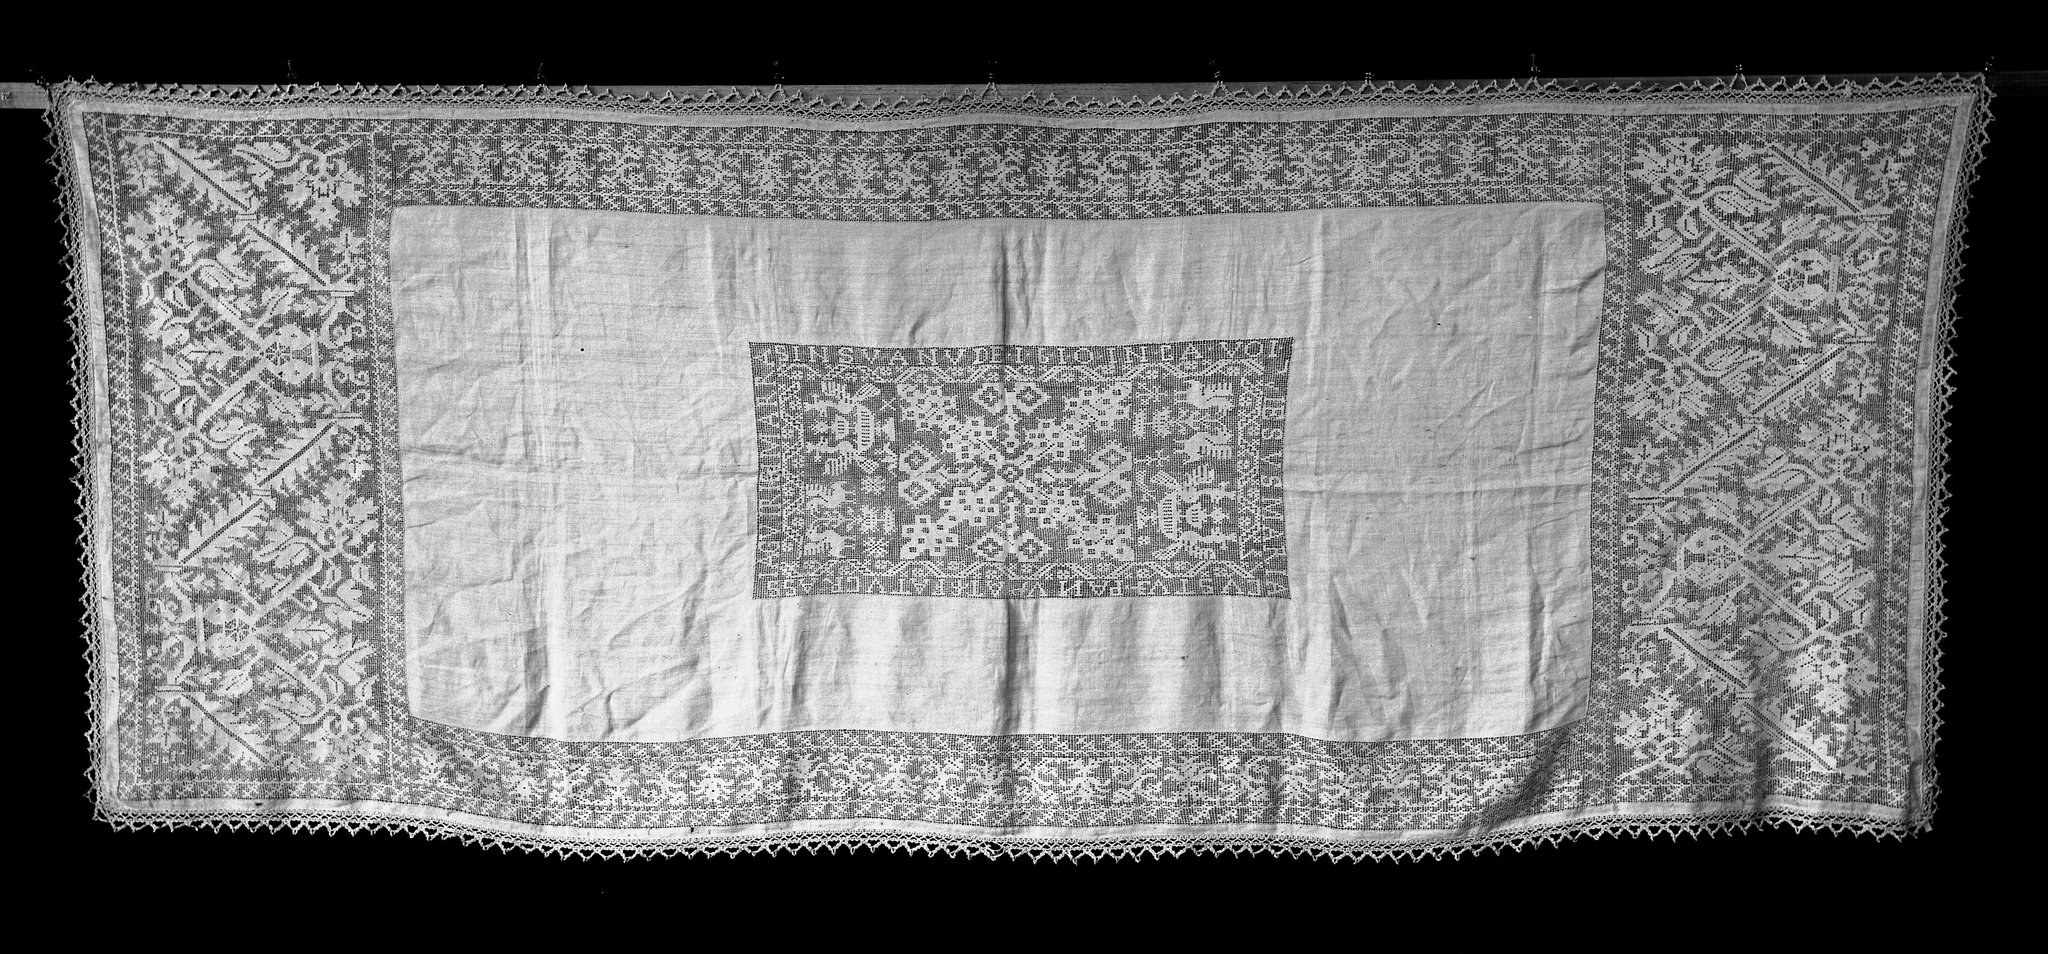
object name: altar cloth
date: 1610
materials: linen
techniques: lace, embroidery